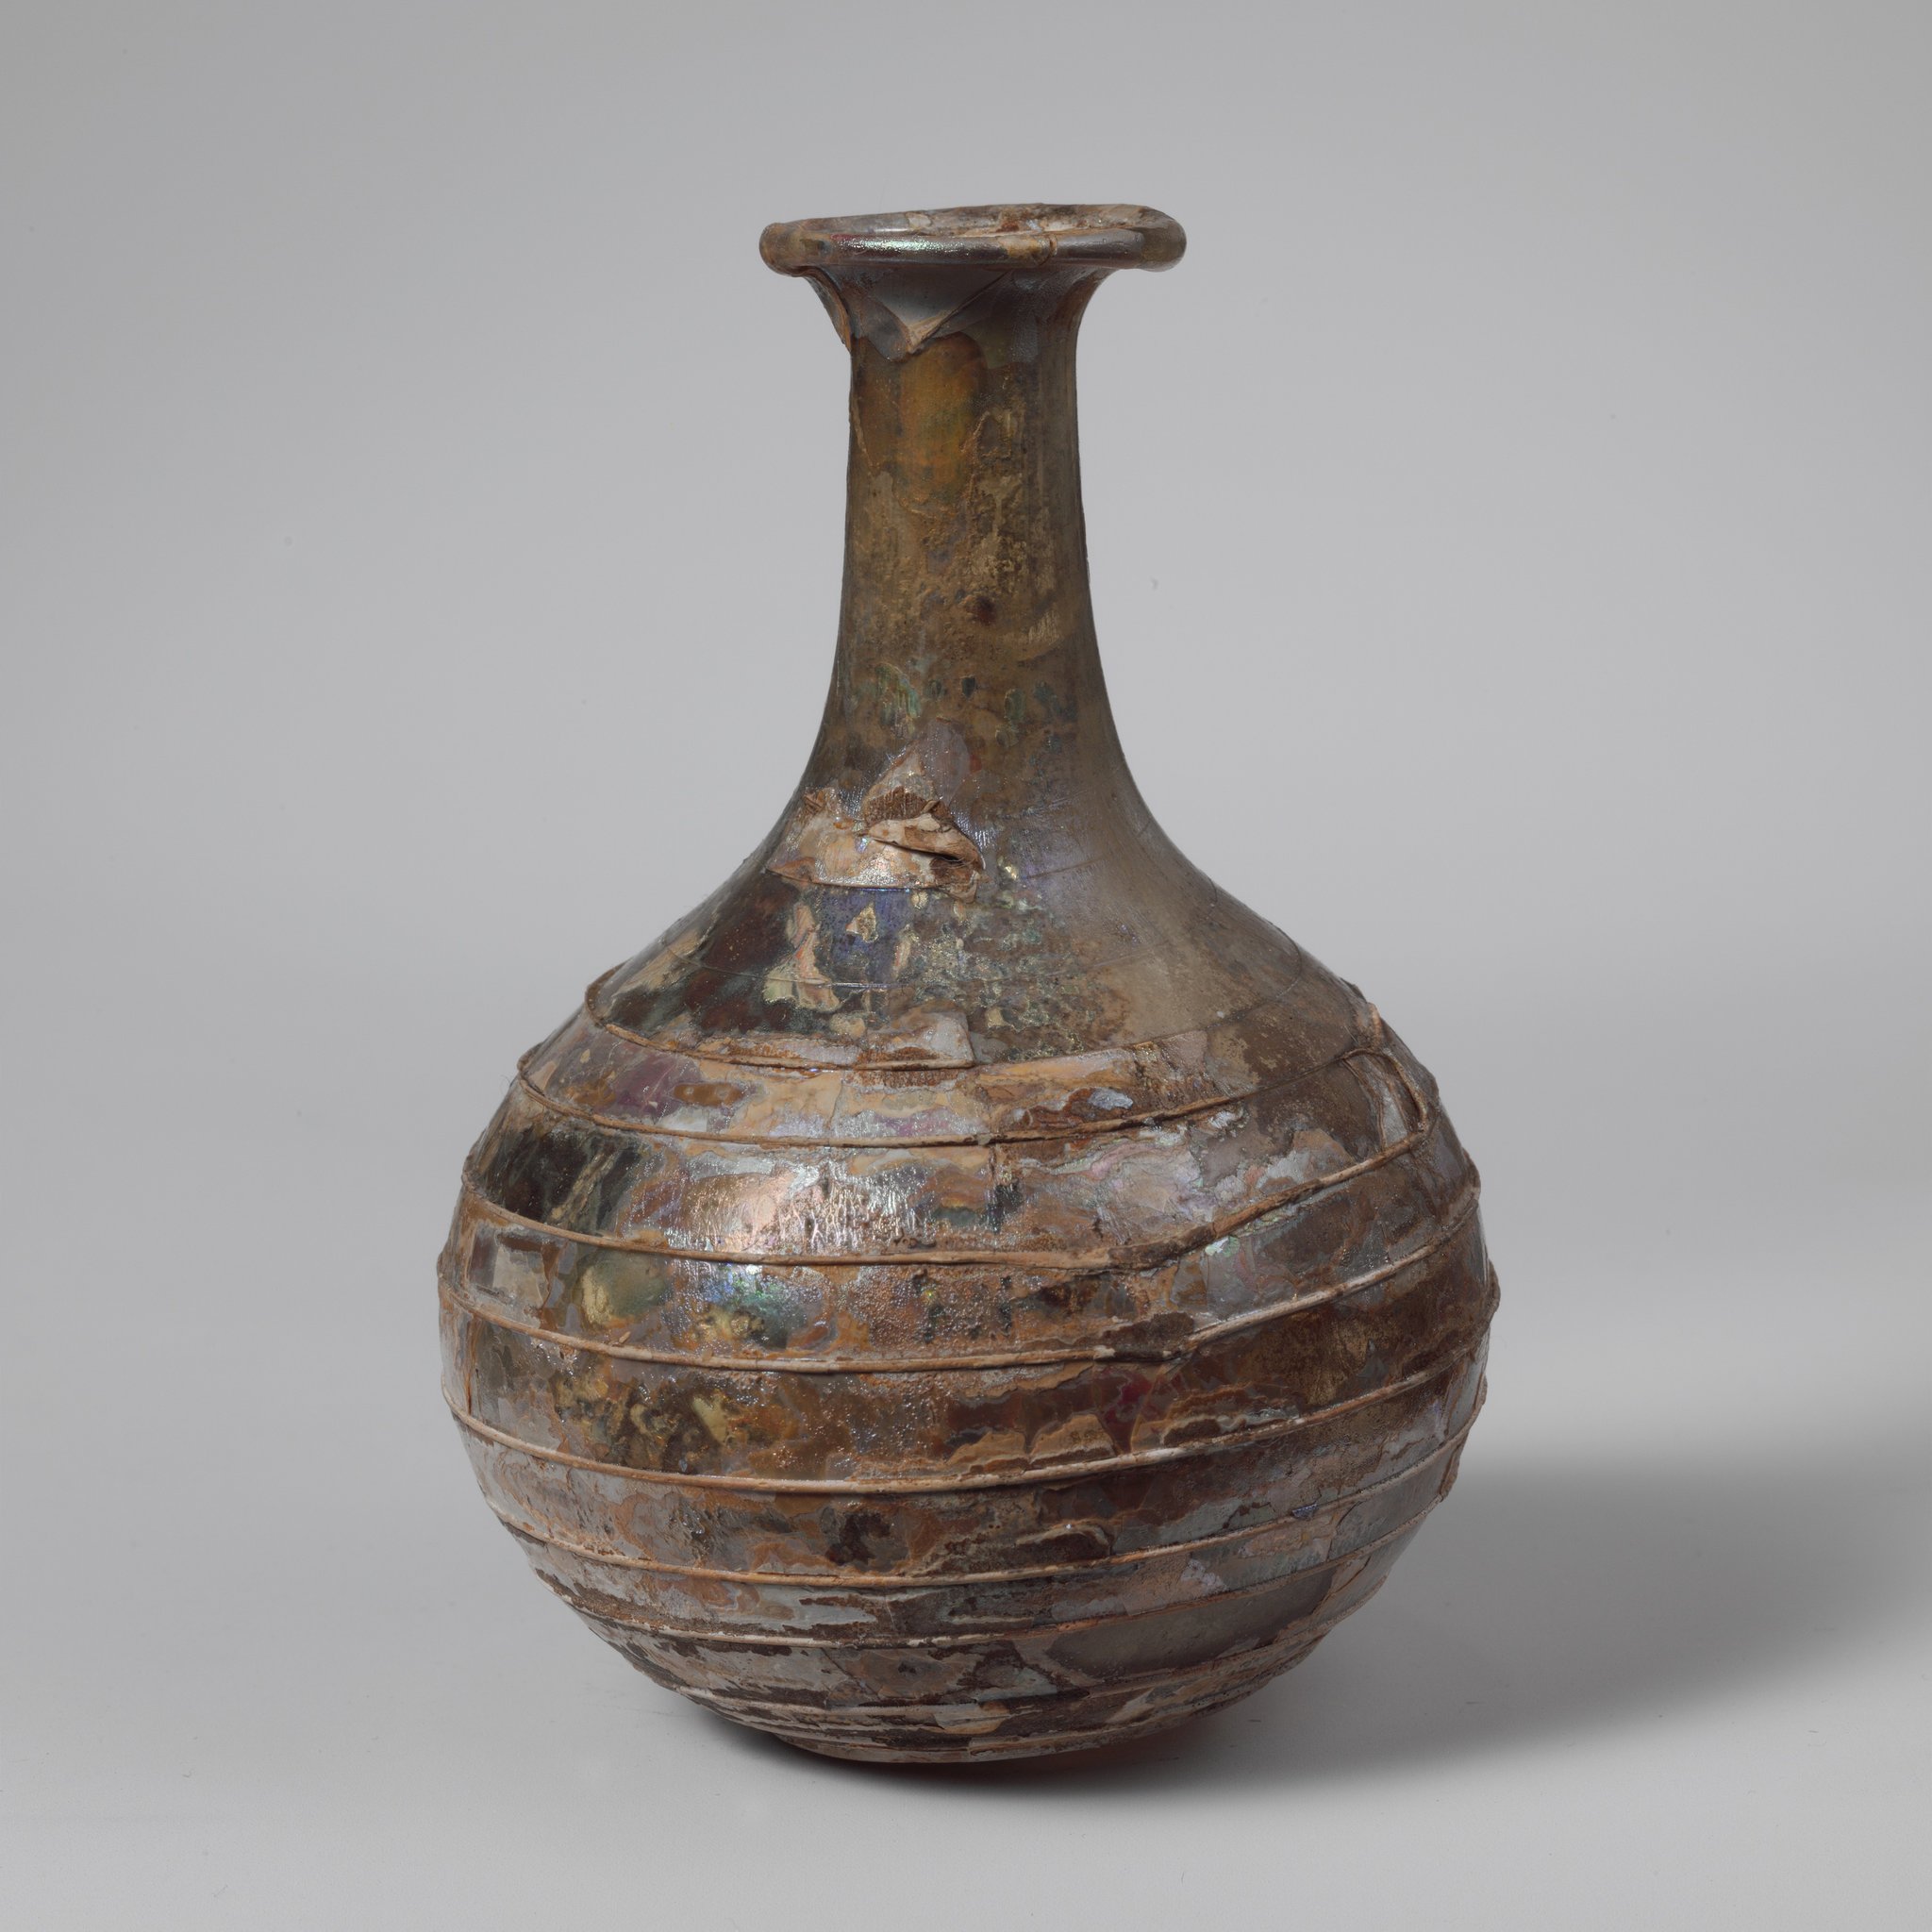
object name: bottle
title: Glass perfume bottle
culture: roman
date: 1-100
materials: glass